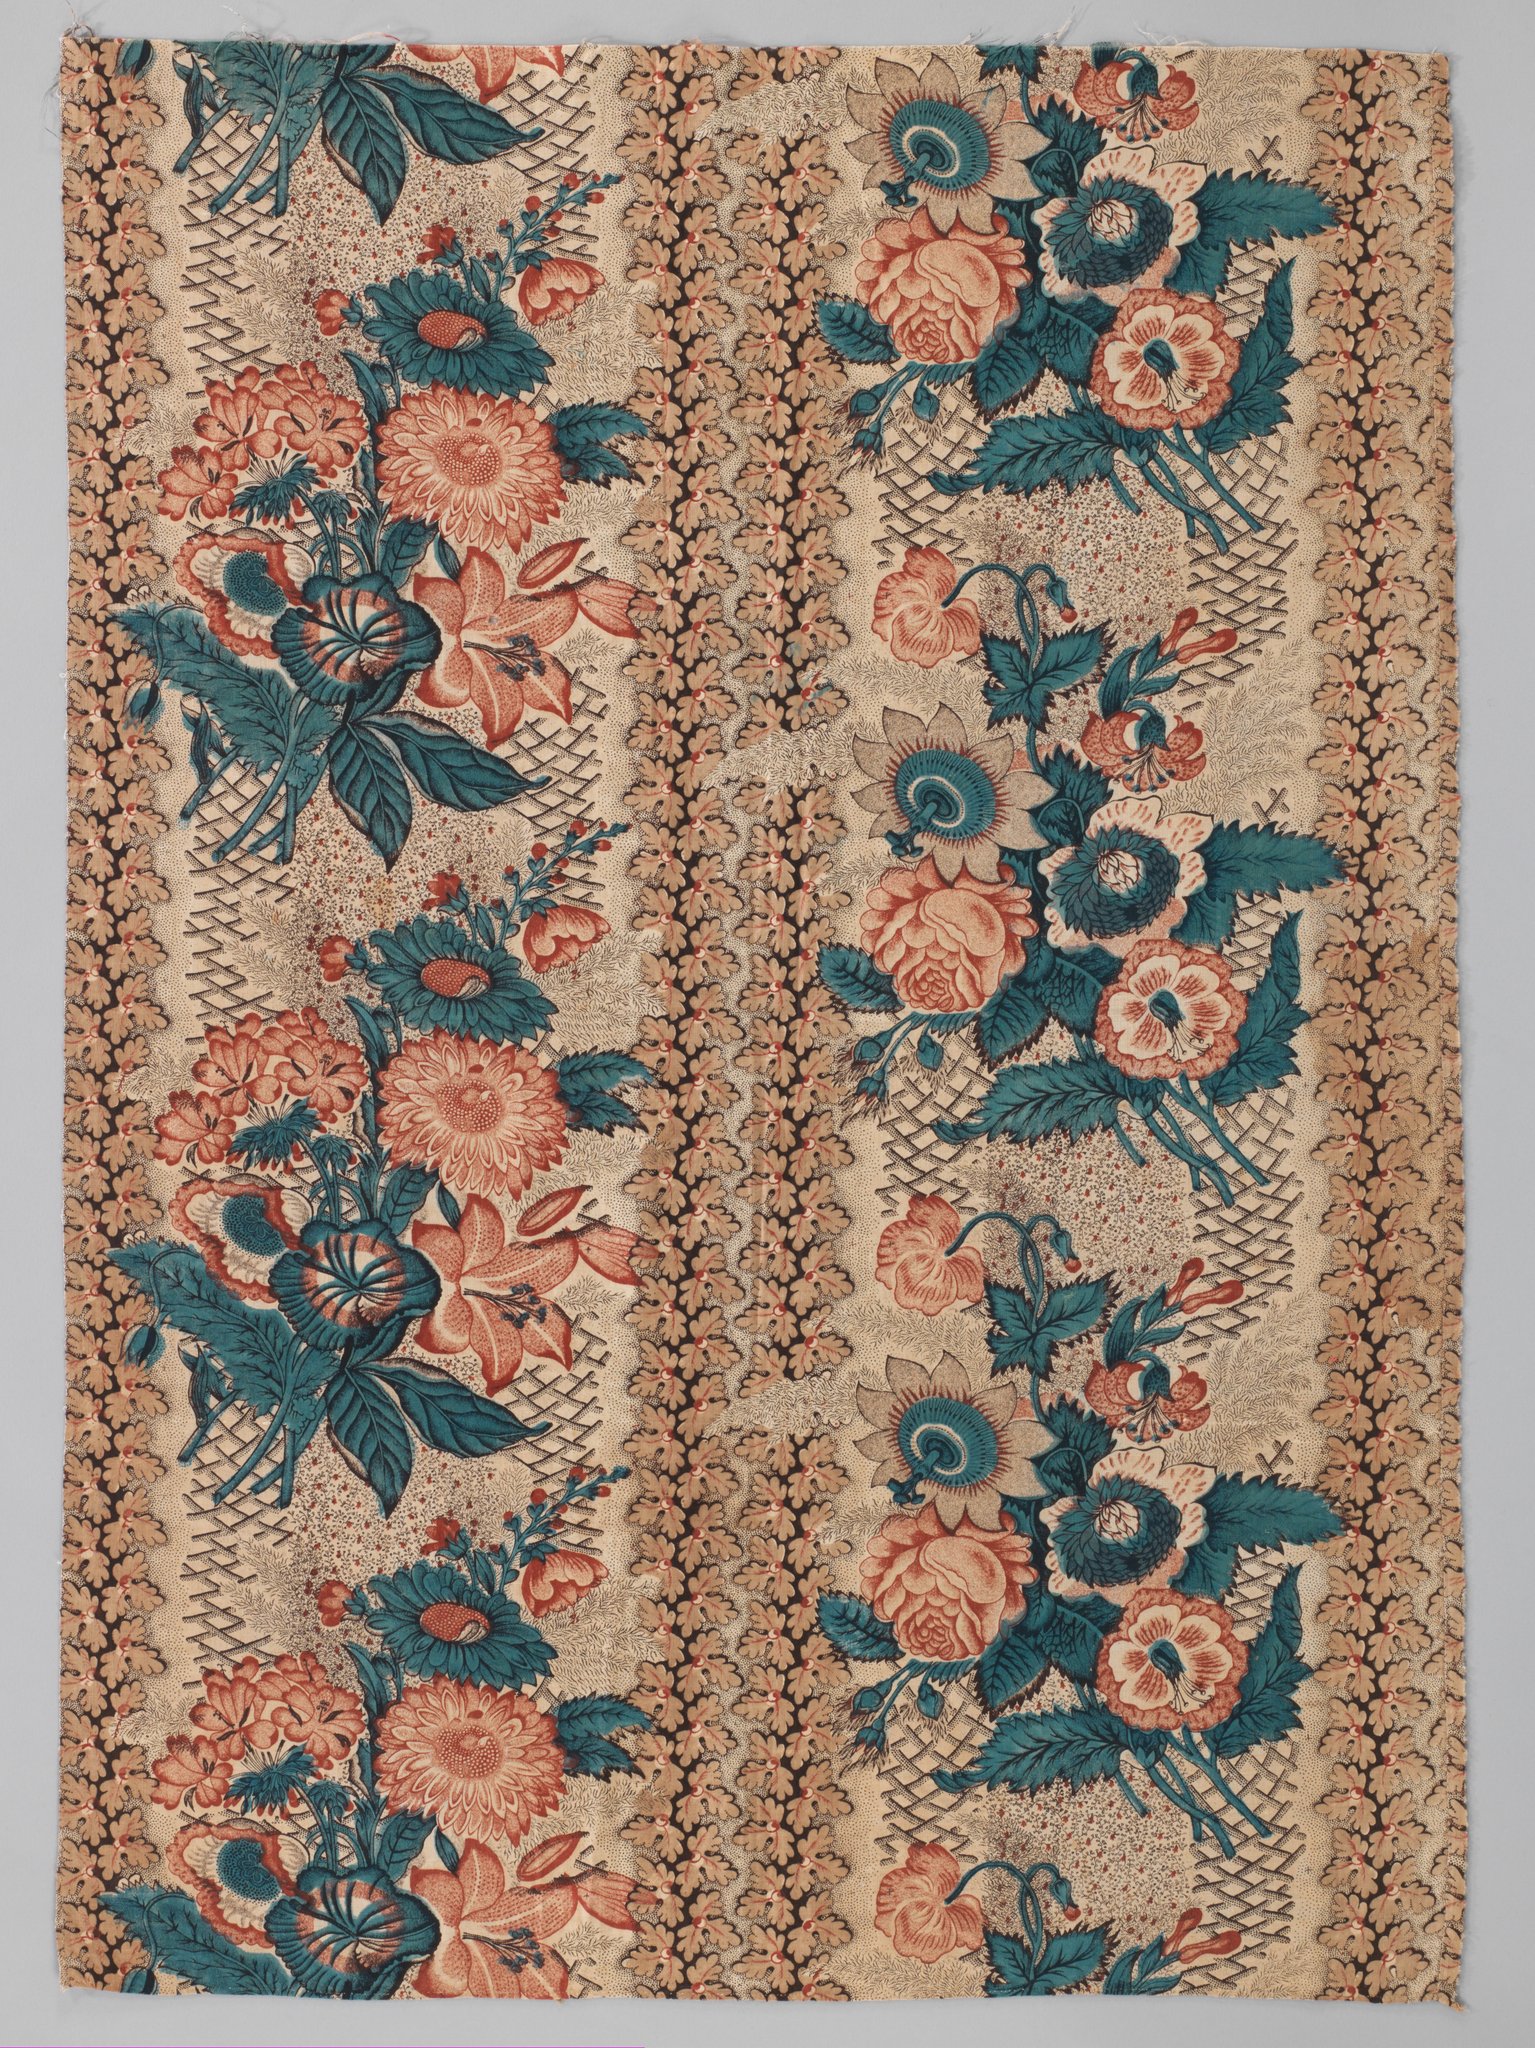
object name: piece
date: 1830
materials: cotton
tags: flowers